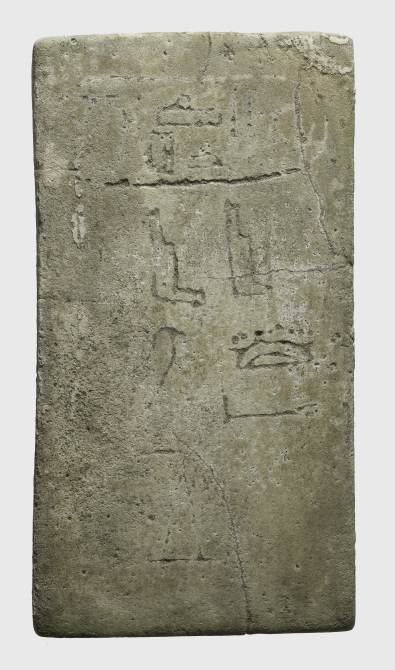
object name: foundation deposit plaque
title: Foundation deposit plaque of Amenemhat I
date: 1981-1952 BCE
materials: faience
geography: egypt